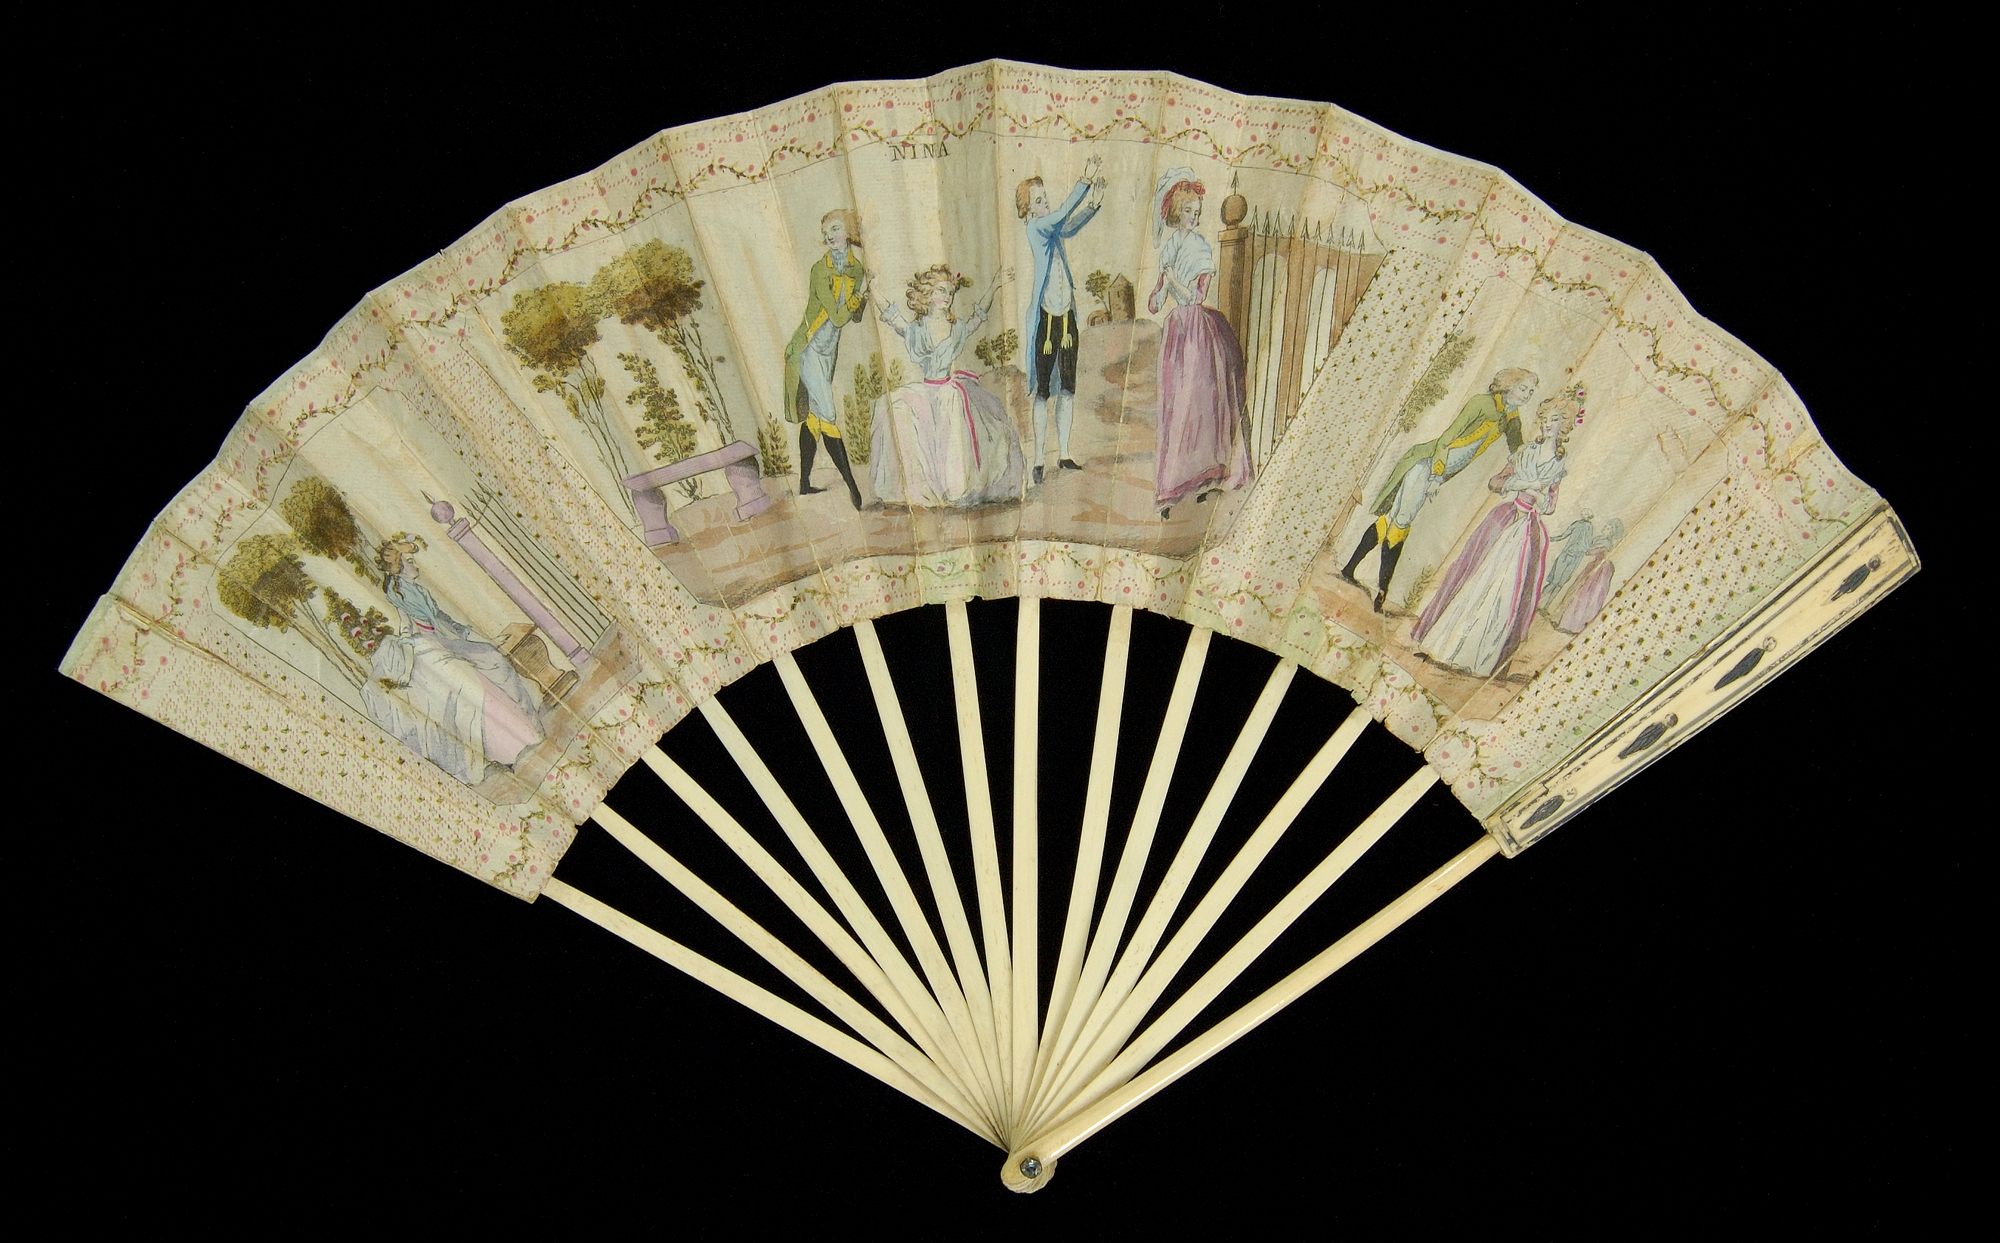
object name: fan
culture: french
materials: glass, ivory, paint, paper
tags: men,women